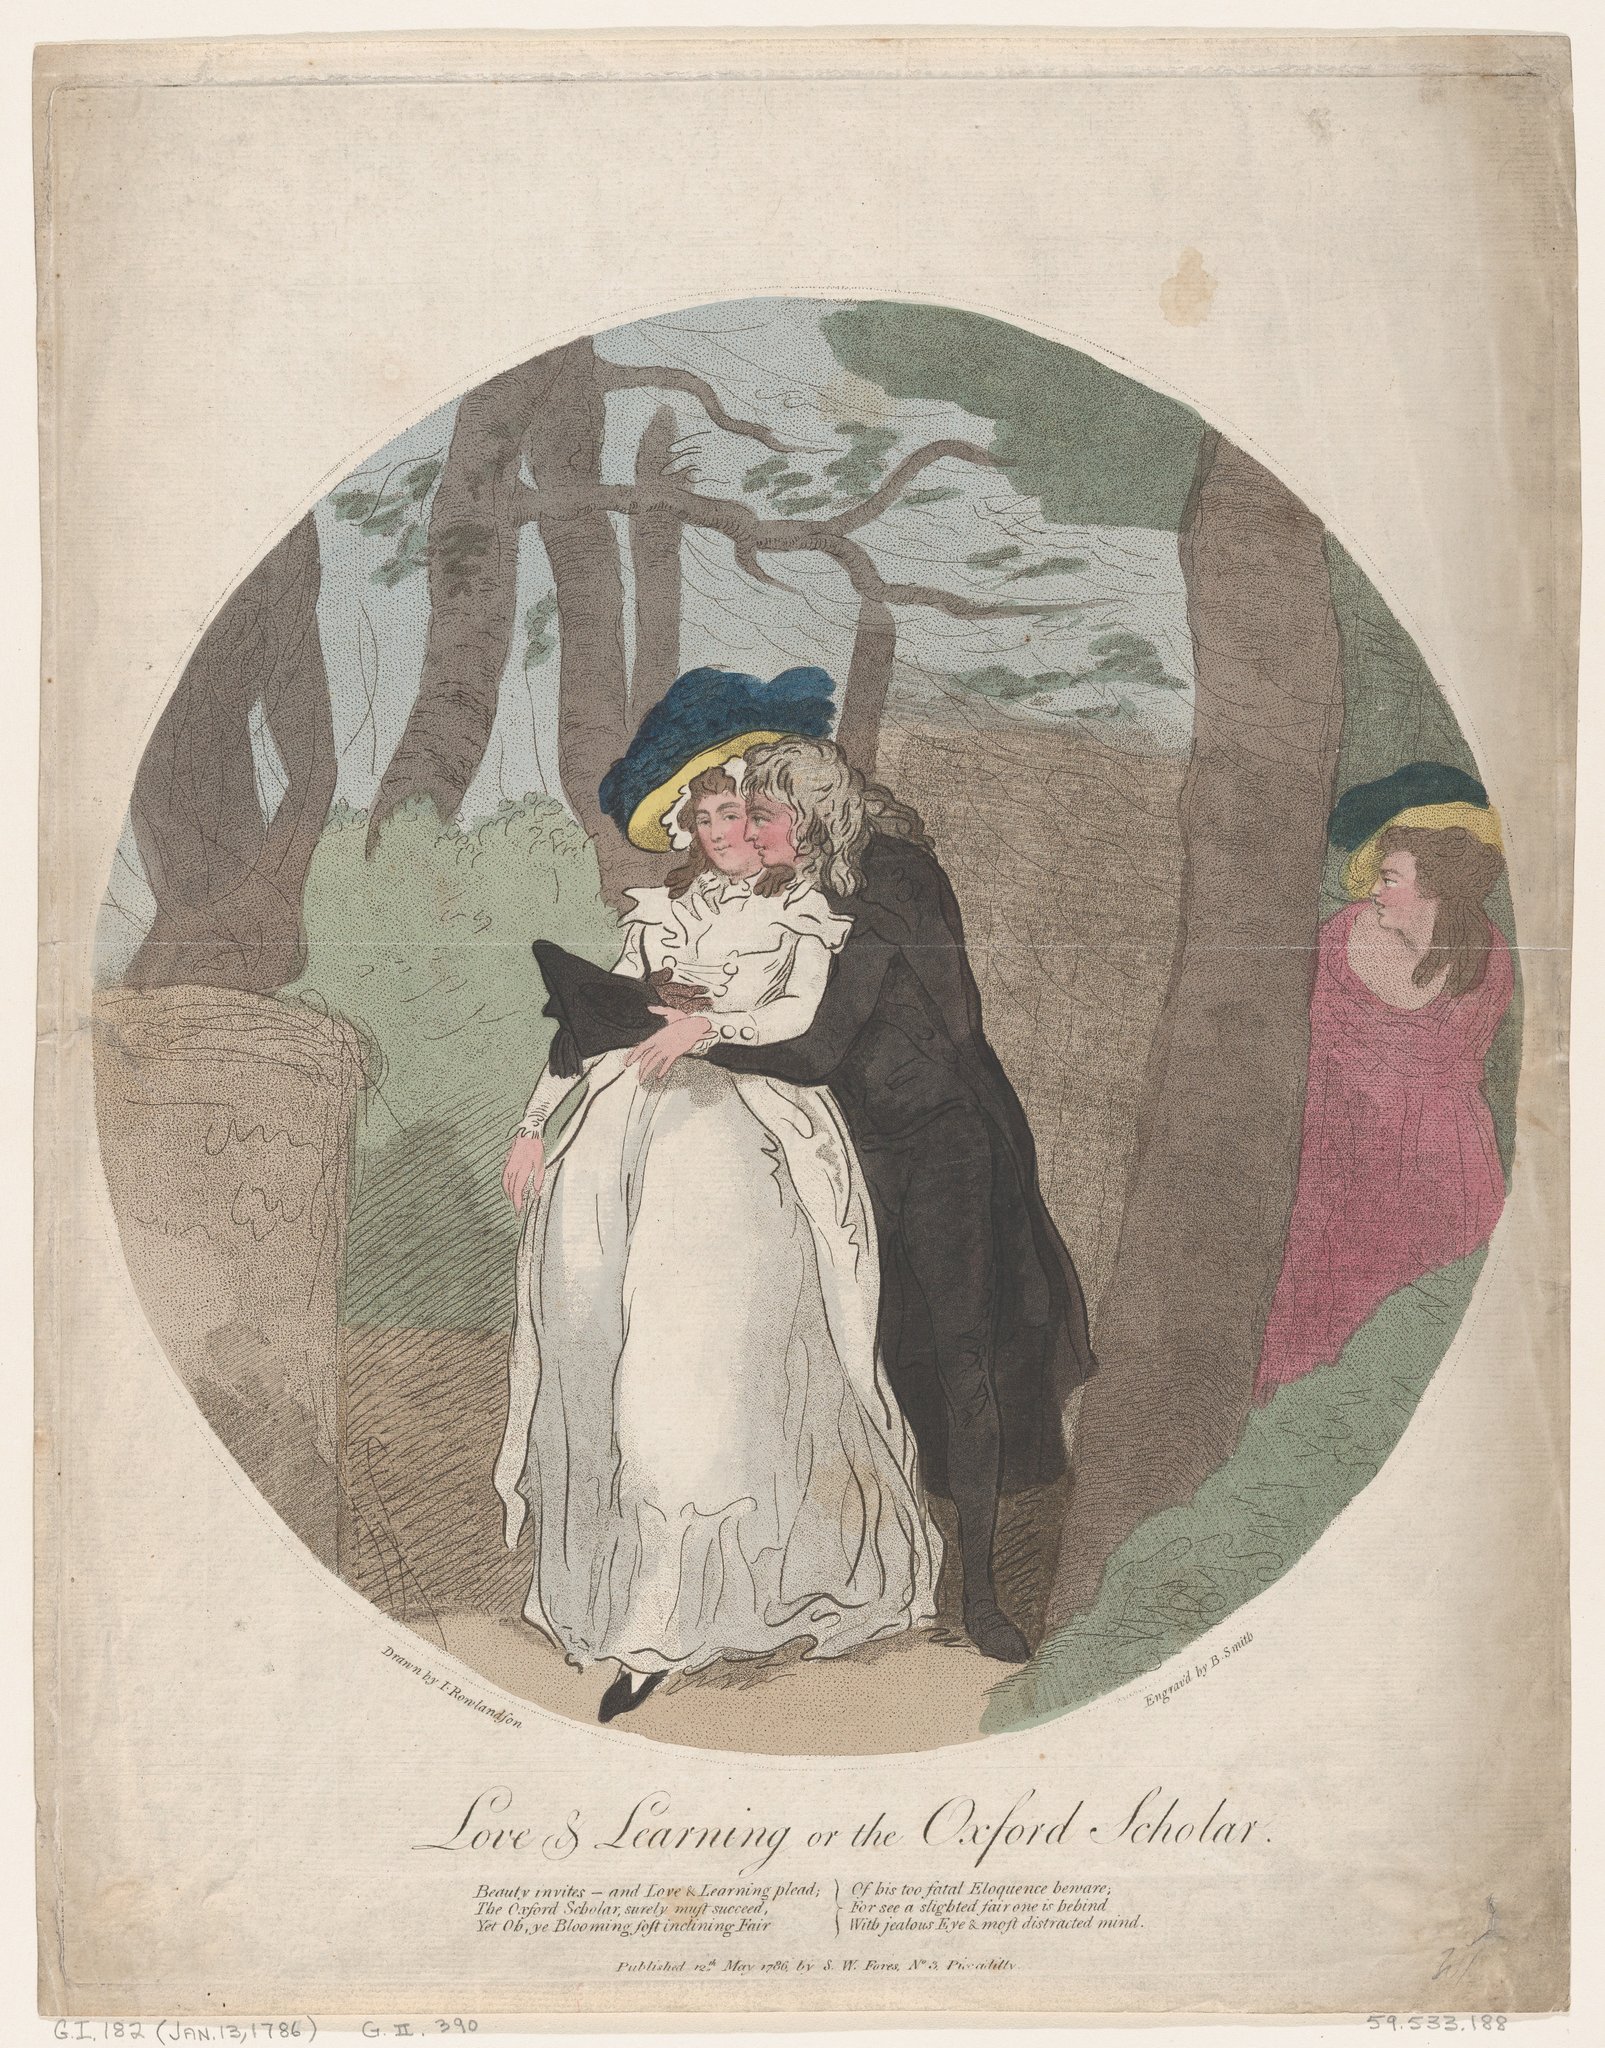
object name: print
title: Love and Learning, or the Oxford Scholar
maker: benjamin smith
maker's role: etcher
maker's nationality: british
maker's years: 1775-1833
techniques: etching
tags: satire,men,women